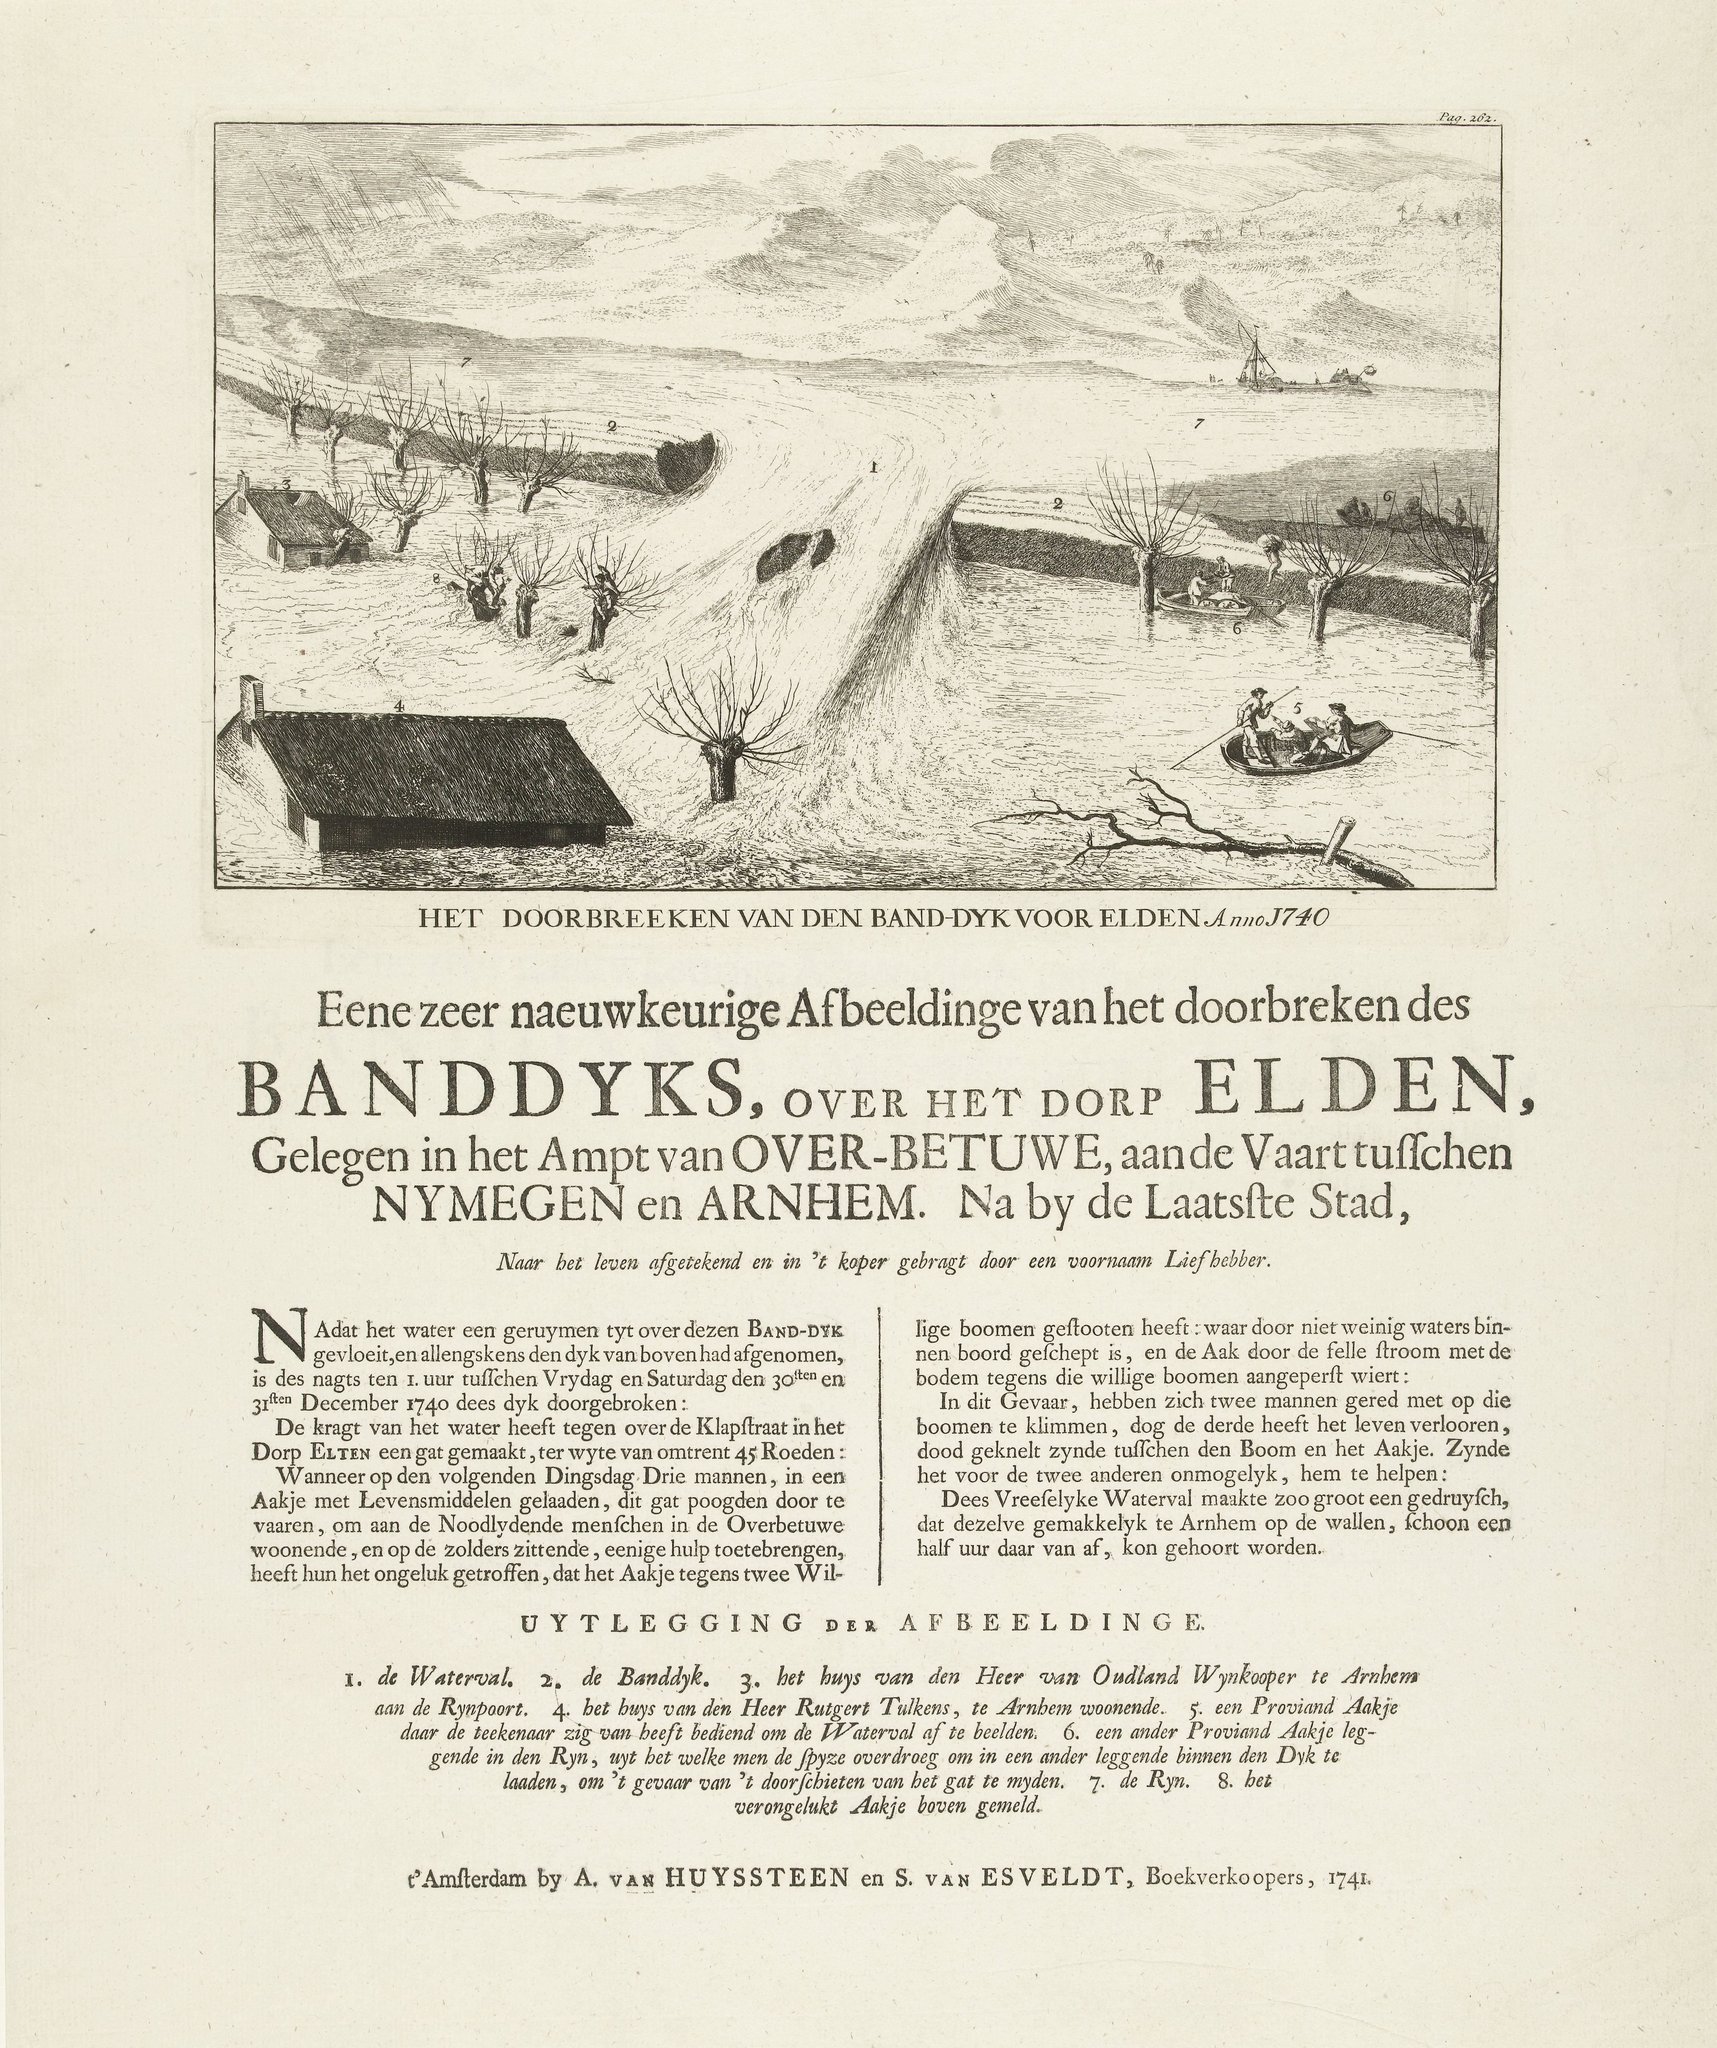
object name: print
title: Het doorbreeken van den band-dyk voor Elden Anno 1740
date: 1741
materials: paper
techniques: etching, letterpress printing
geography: amsterdam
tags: dike-break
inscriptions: collector's mark: Lugt 2228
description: Gebruikt (zonder de beschrijving) als illustratie in: Een historiesche beschryving van duure tyden, hongersnoden en watervloeden (...). Inzonderheid in de bedroefde zomer van den jaare 1709; en't geheele jaar 1740. Amsterdam: A. van Huyssteen en S. van Esveldt, 1741, blz. 91.